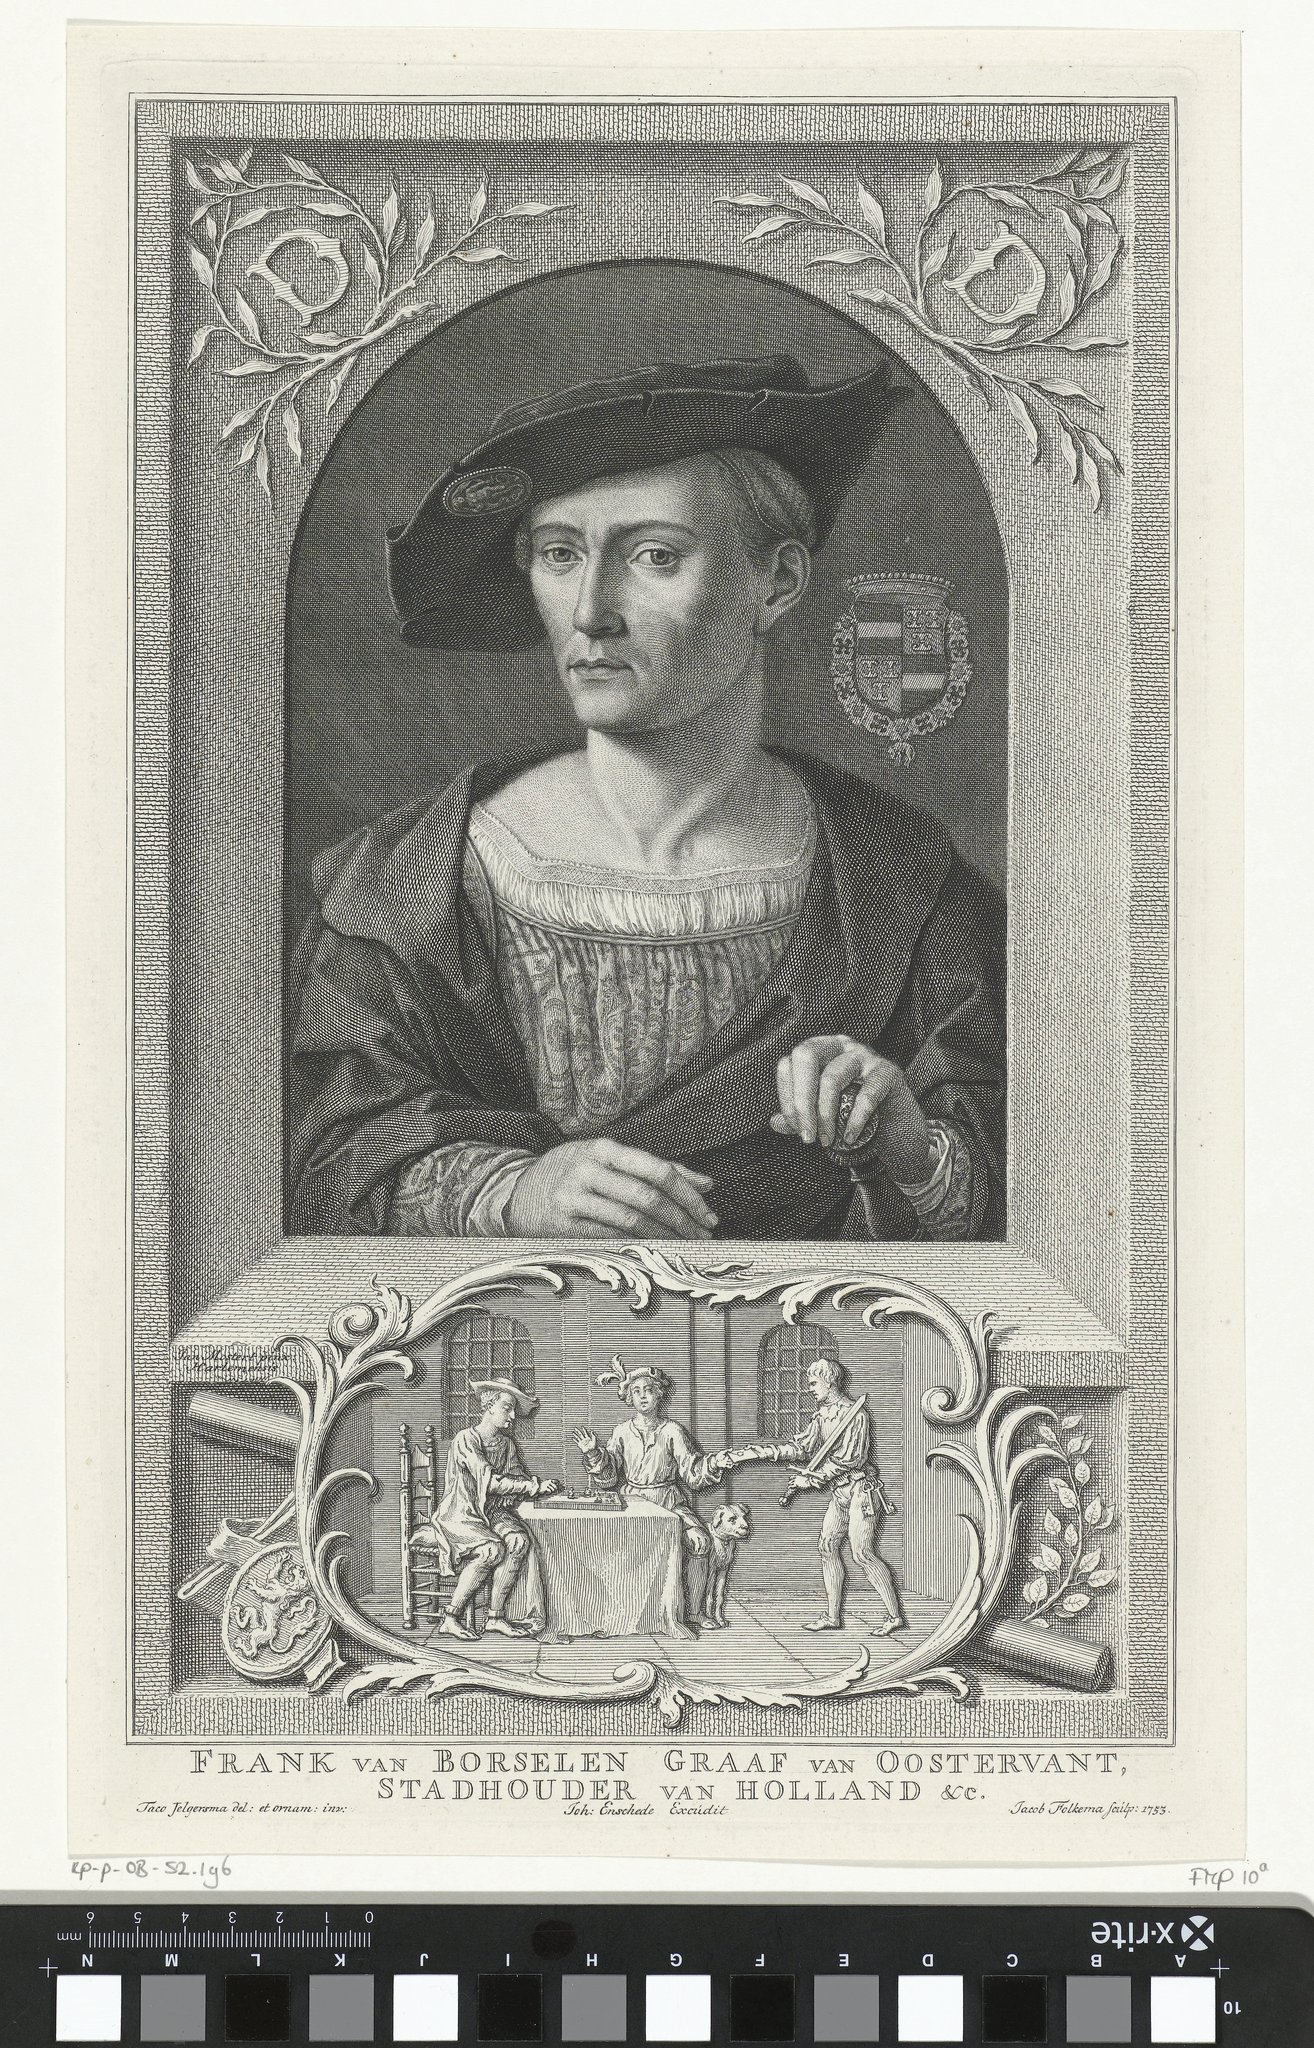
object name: print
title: Portret van Frank van Borselen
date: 1753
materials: paper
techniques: etching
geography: haarlem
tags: board-games (+ sportsman, player, etc.)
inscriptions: collector's mark: Lugt 240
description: Portret ten halven lijve van voren van de Zeeuwse edelman Frank van Borselen, met hoed. Rechts van de edelman is een gekroond wapenschild weergegeven. Onder het portret is een spel spelend gezelschap afgebeeld, omgeven door een sierlijke lijst. In de marge staan de naam en titels van de geportretteerde.